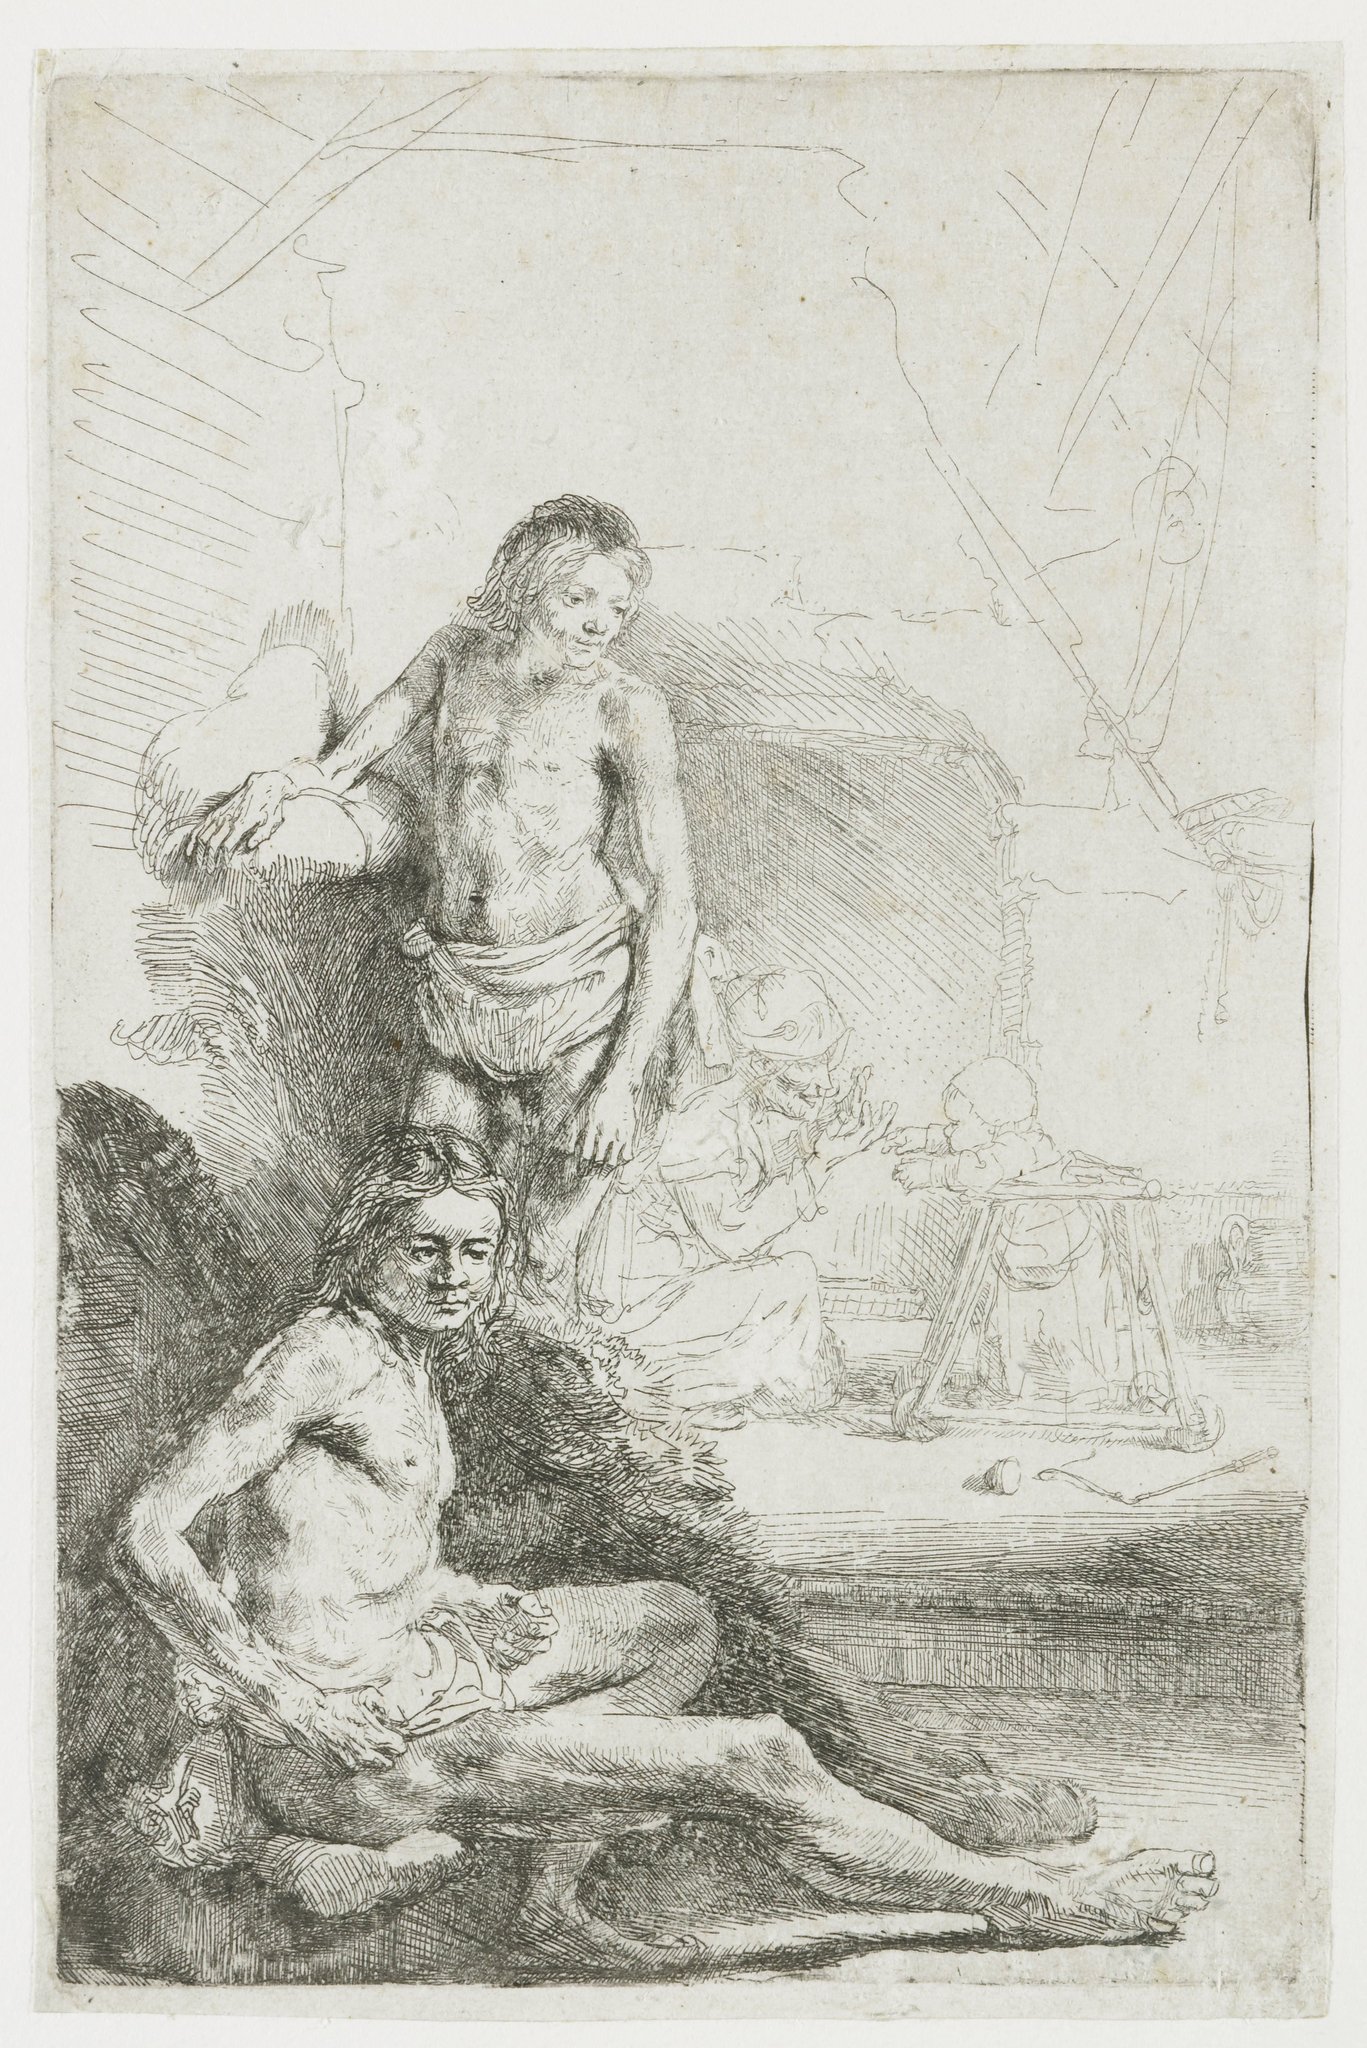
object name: print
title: Male nude, seated and standing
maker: rembrandt van rijn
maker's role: draughtsman, painter, print maker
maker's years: 1606-1669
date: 1646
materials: paper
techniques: etching, intaglio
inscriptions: collector's mark: Lugt 2165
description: Behind the two sketches of the same man, one seen standing, the other seated, Rembrandt added a woman teaching a toddler to walk using a baby walker. Learning how to walk is a frequently recurring 17th-century metaphor for practice: a subtle reminder from Rembrandt to his pupils that they can master their craft only through constant practice.